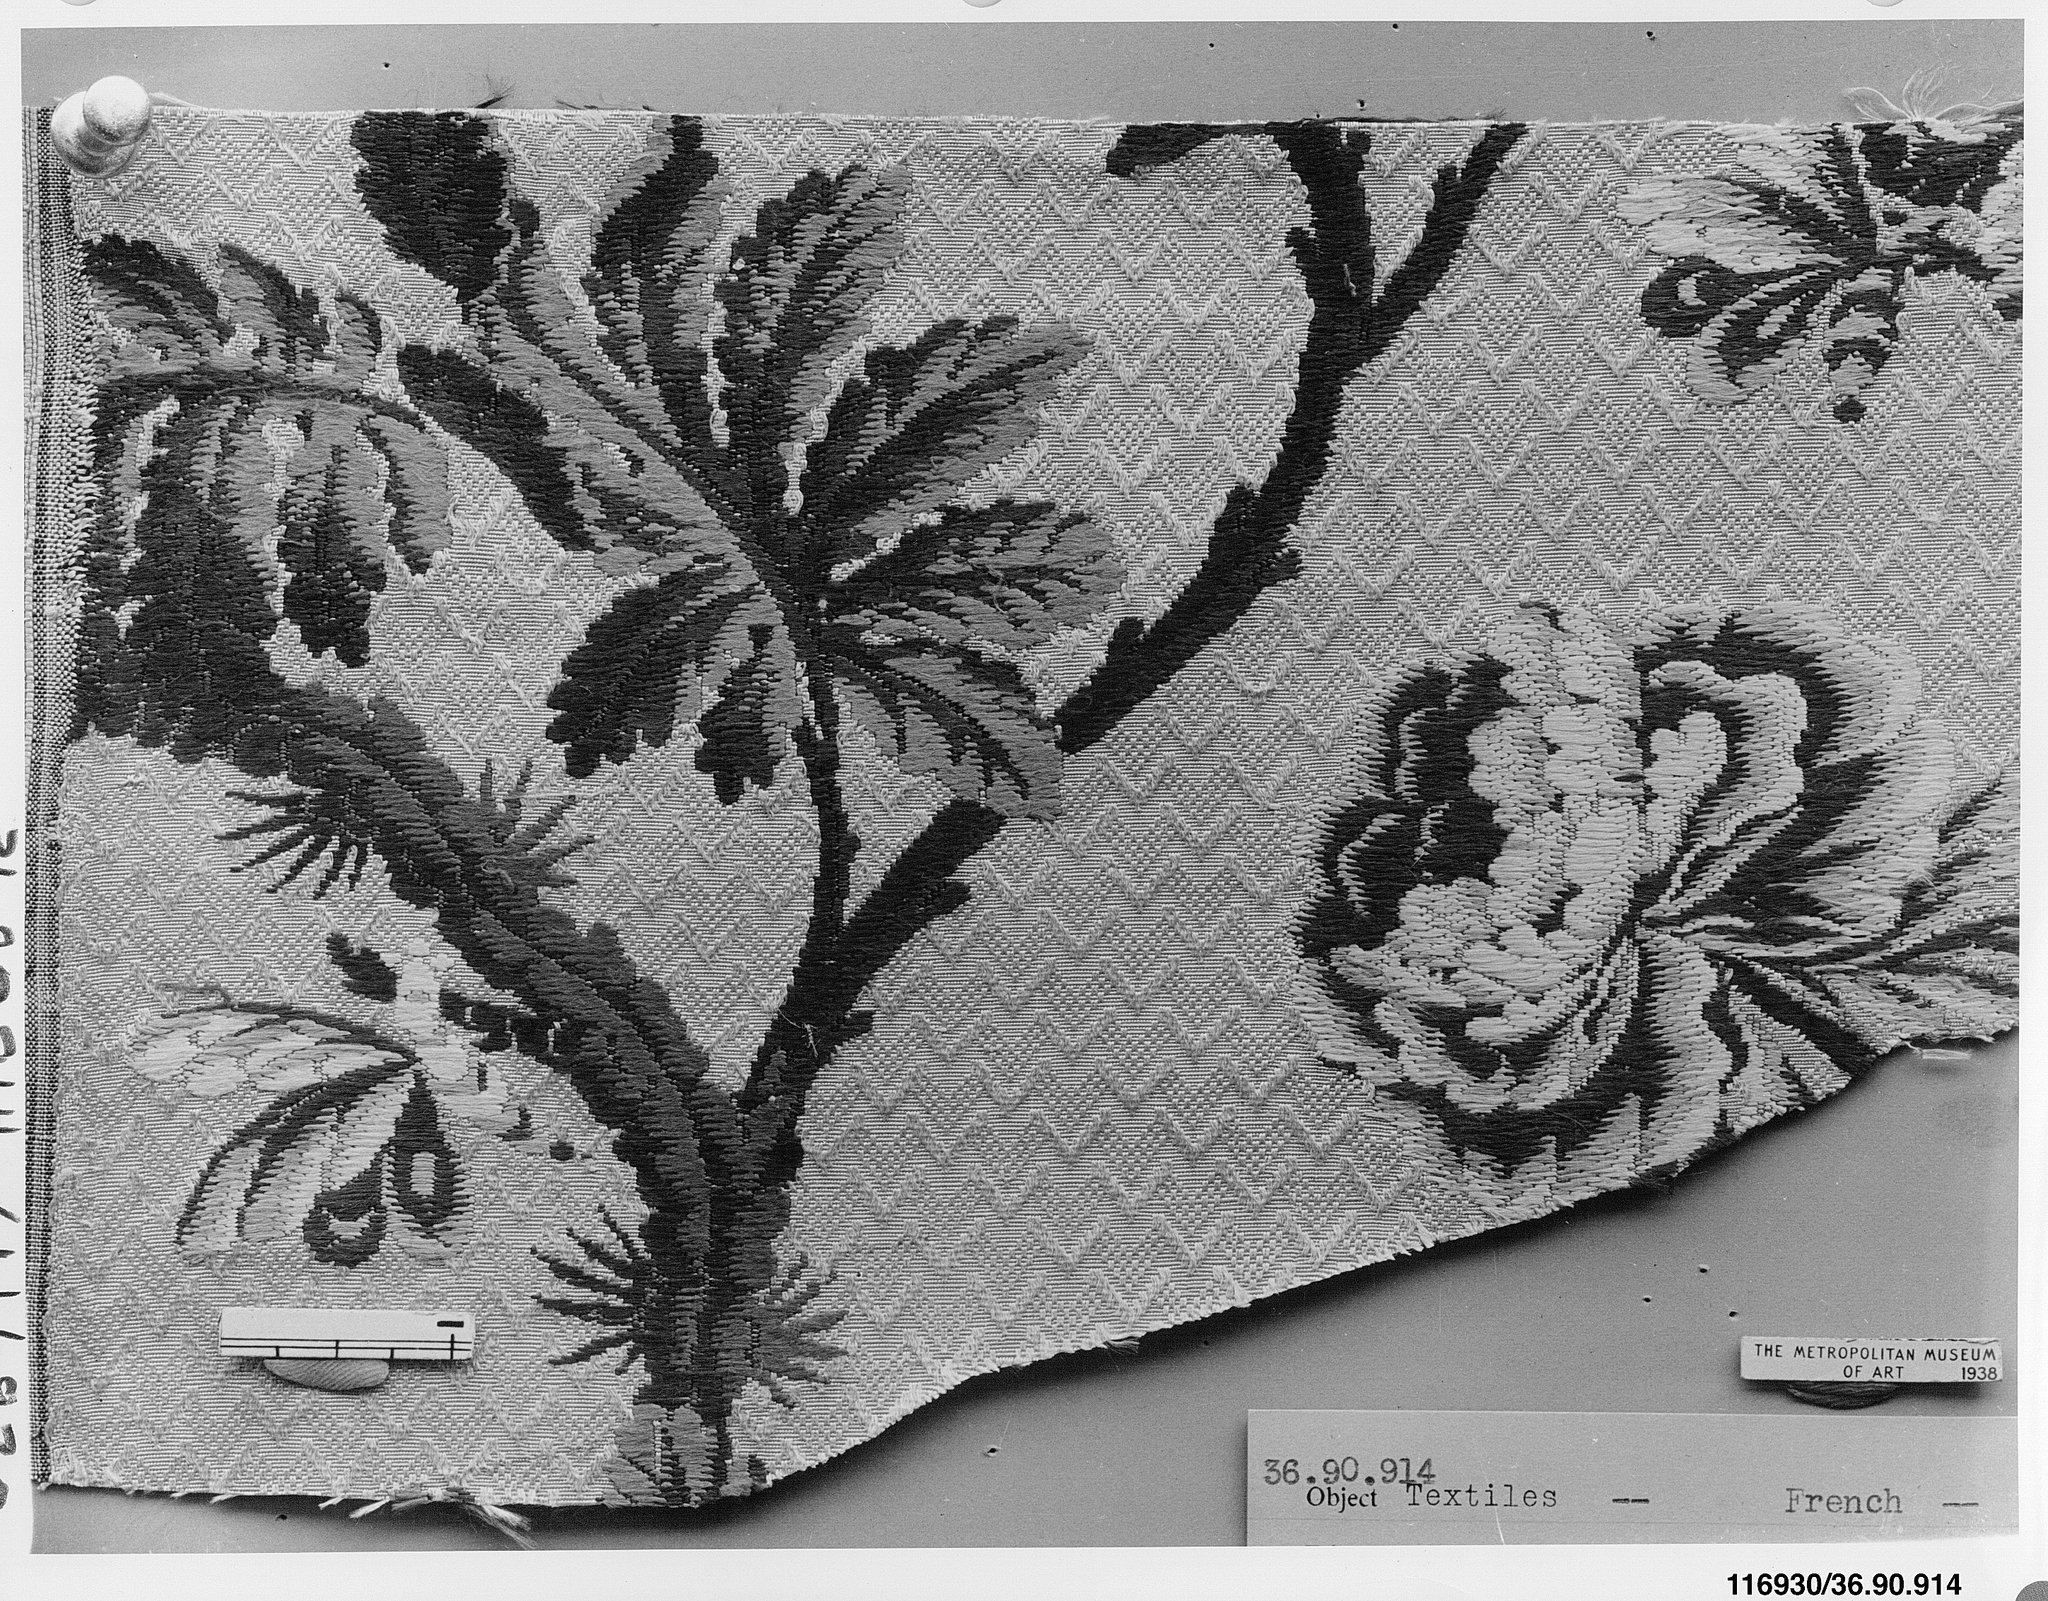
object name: piece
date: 1735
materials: silk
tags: flowers,leaves